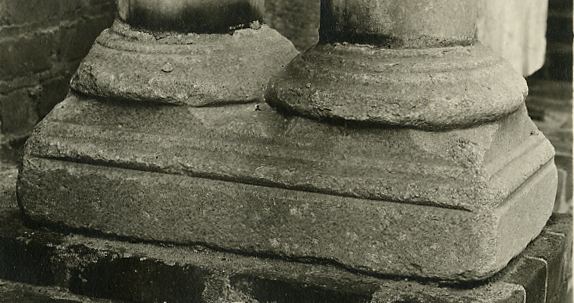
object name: base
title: Double Column Base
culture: french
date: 1267-1333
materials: marble